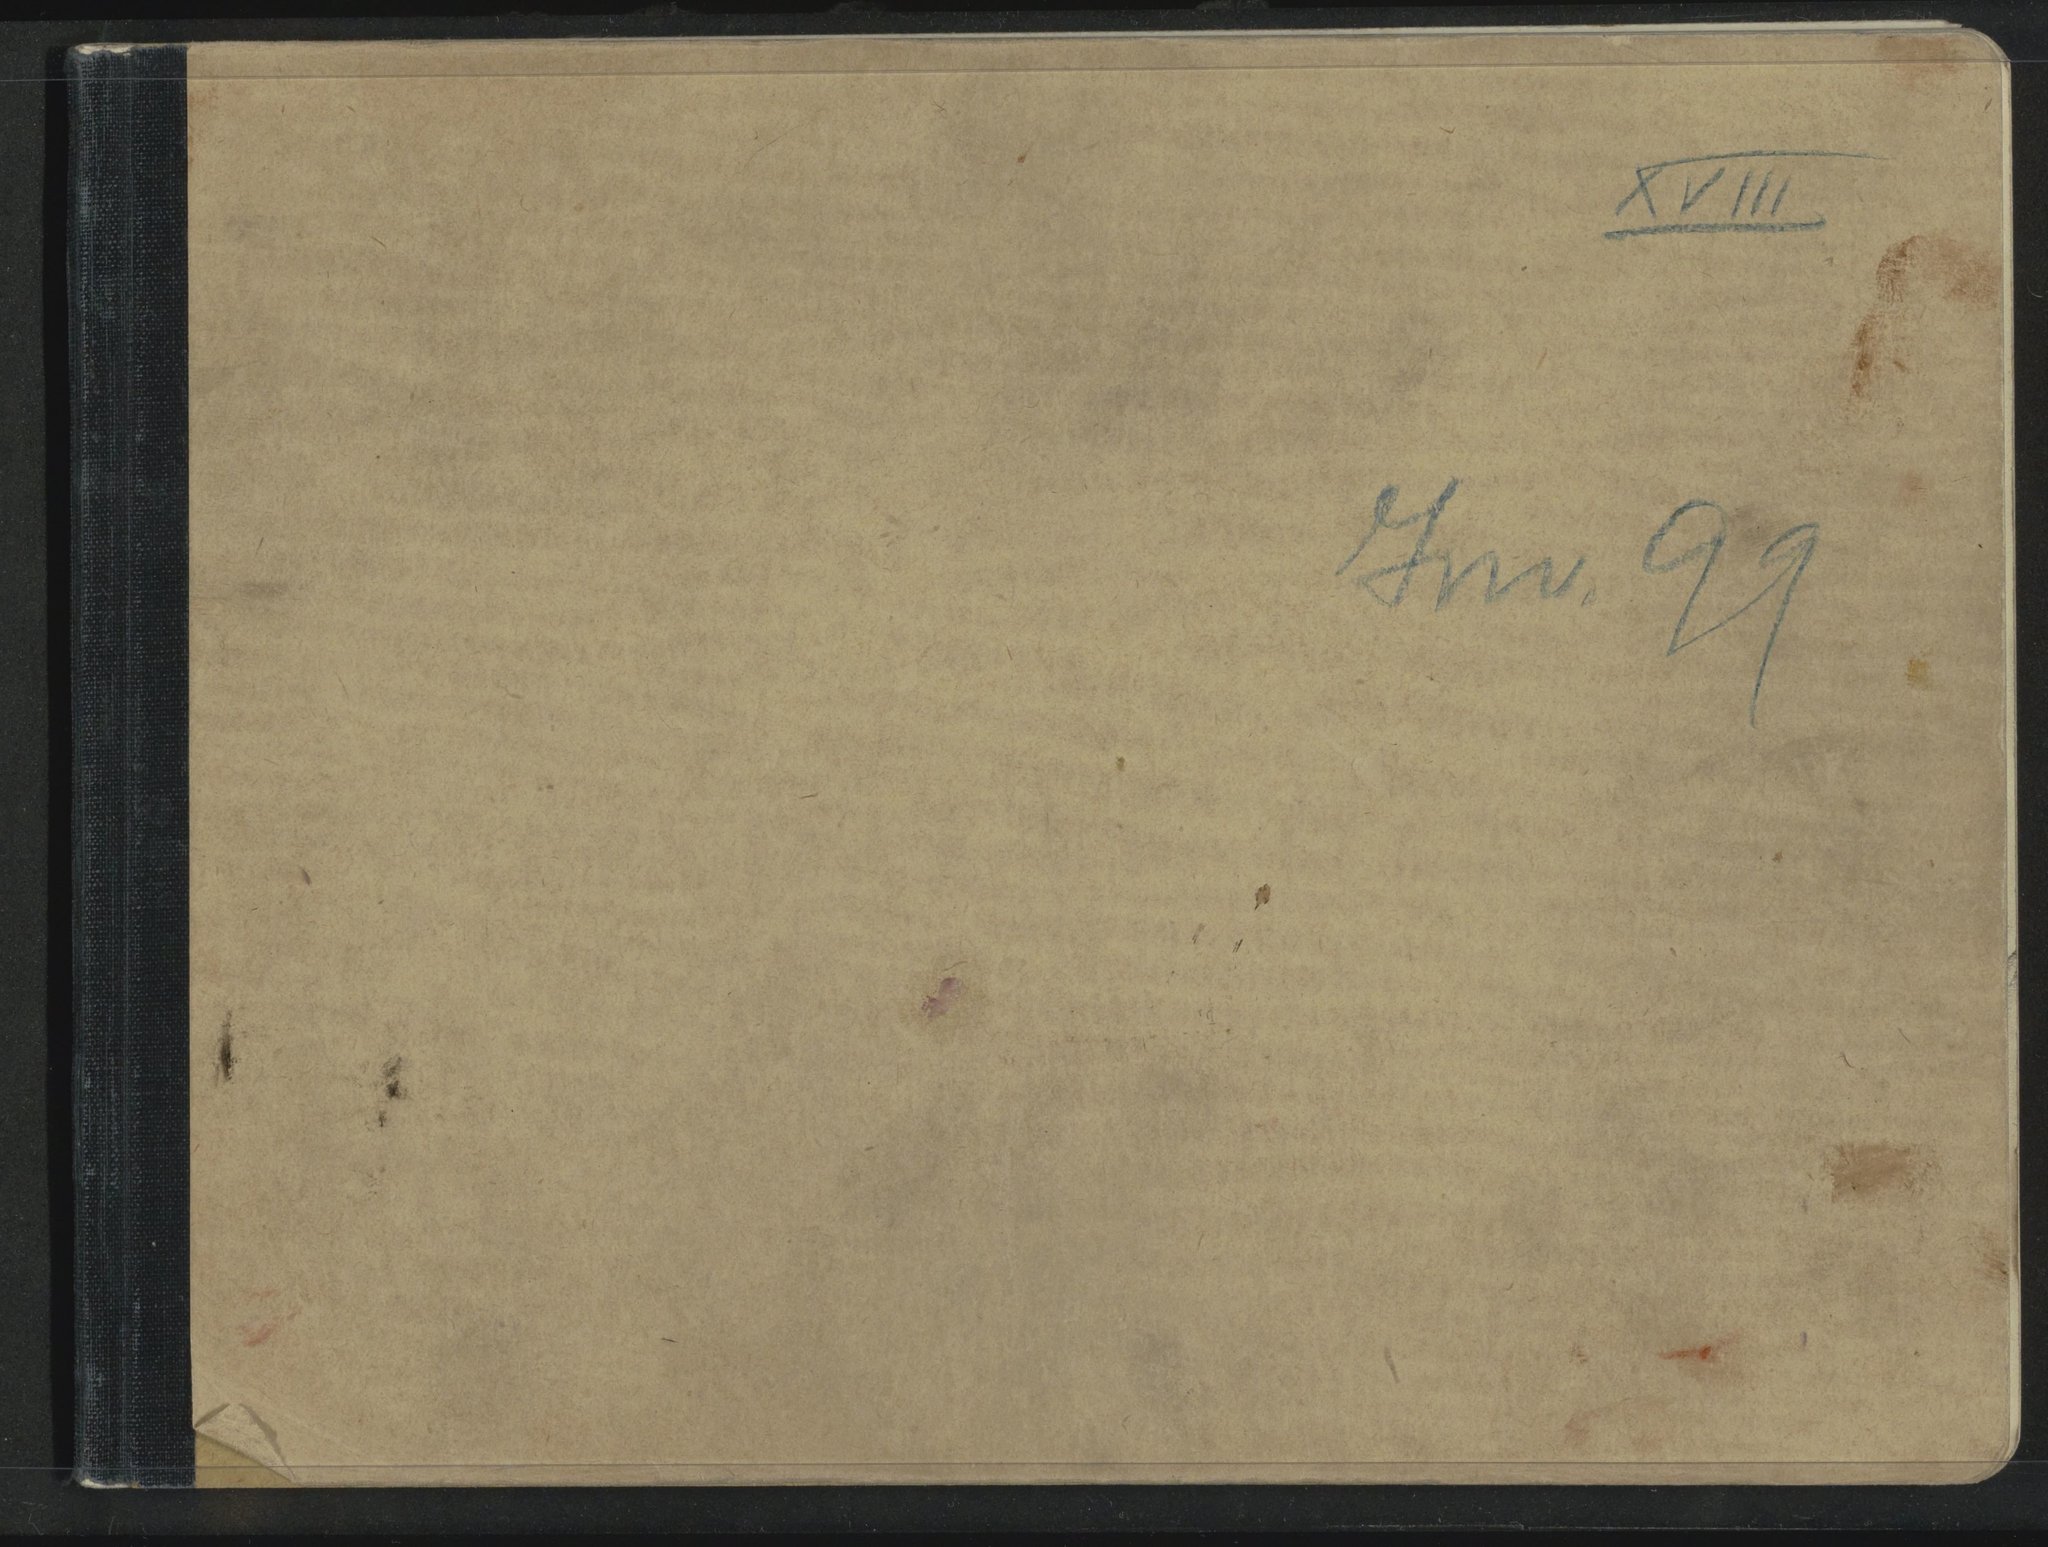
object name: sketchbook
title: Schetsboek XVIII met 35 bladen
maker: isaac israels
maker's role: draughtsman, painter, print maker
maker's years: 1865-1934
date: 1915-1934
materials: cardboard, linen, paper, pencil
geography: the hague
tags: vaudeville, variety-show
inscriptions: retailer's mark: ‘W.M. Stam / Den Haag / 15 Papestraat’, factory mark: ‘HvS / No. 631’, collector's mark: Lugt 2228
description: Bladen 1(V), 4(V), 5(V), 6(R), 7(V), 8(R), 9(V), 10(R), 12(V), 13(R), 14(R), 15(V) t/m 18(R), 19(V) t/m 21(R), 30(R), 32(V), 33(R), 34(R) en het voorste schutblad zijn blanco en daarom niet beschreven.